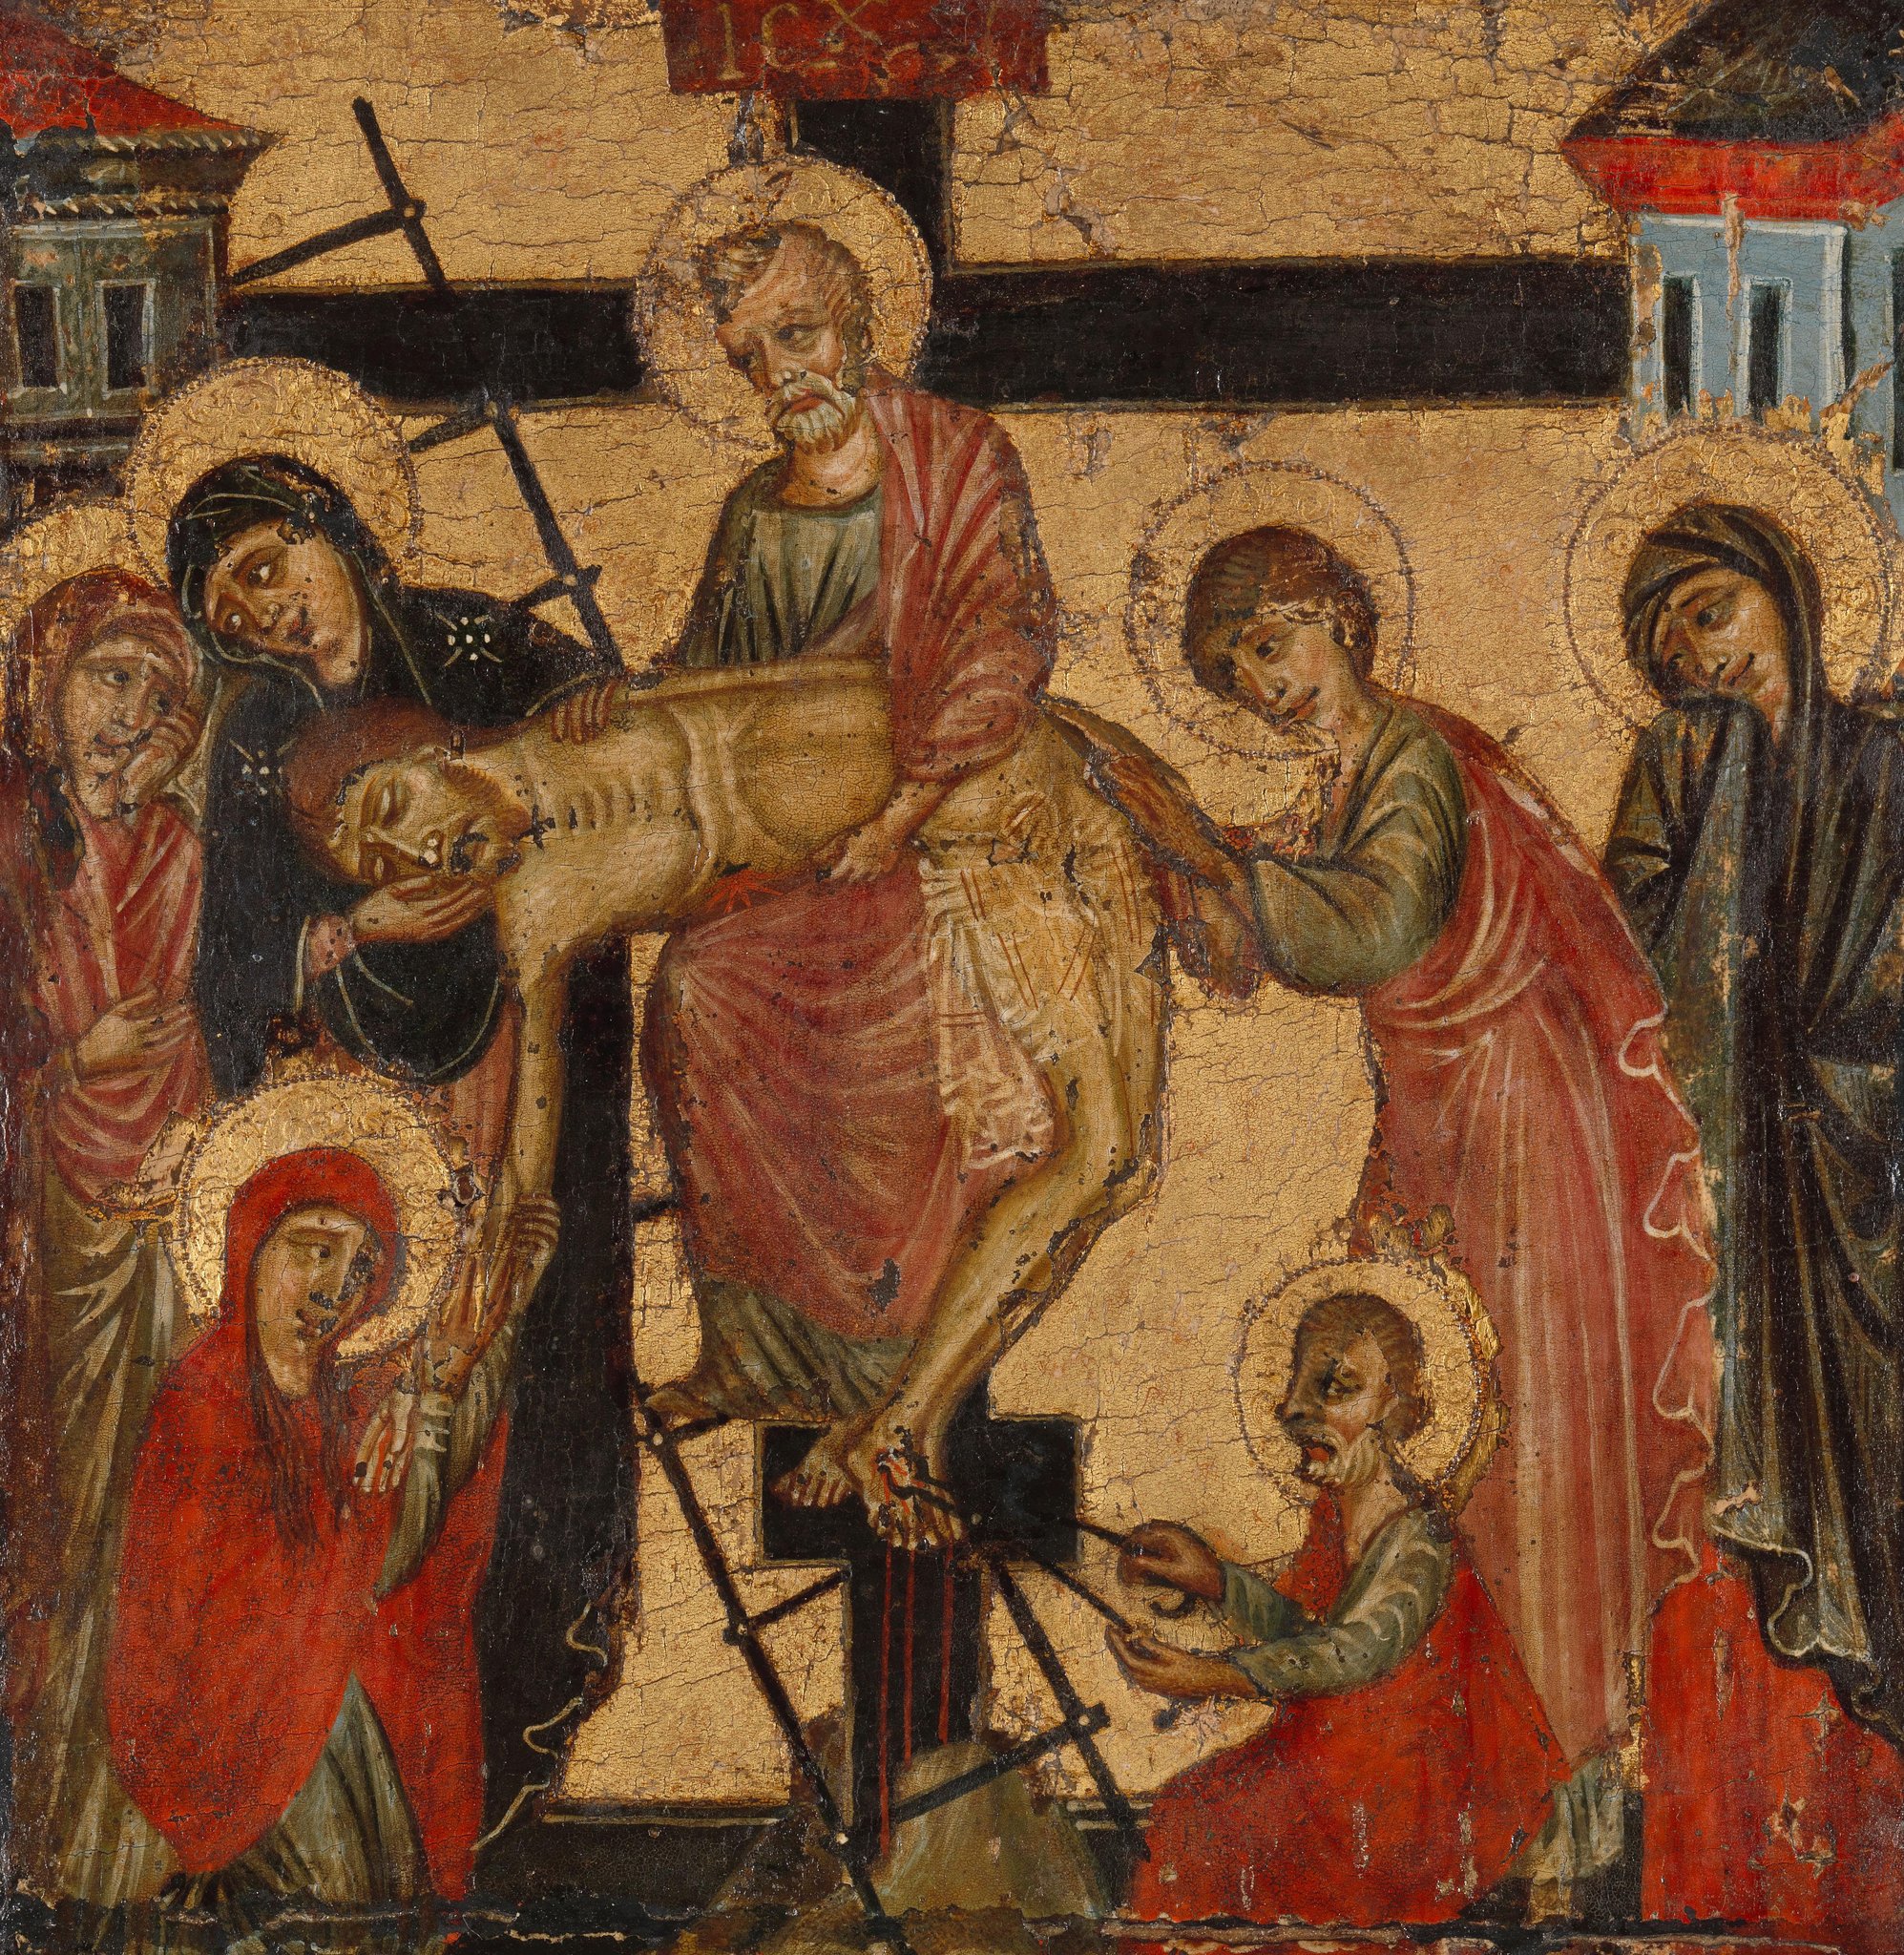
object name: fragment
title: The Deposition and the Entombment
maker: corso di buono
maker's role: painter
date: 1290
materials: panel, paint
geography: pisa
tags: descent from the cross: christ is taken down from the cross, usually by nicodemus and joseph of arimathaea who are standing on the ladders (both arms of christ detached)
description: These two panels are probably fragments from a larger ensemble devoted to the Passion of Christ. The artist followed established conventions for depicting grief and sorrow through gesture. This approach was characteristic of the stiff, rather formulaic style derived from Greek and Byzantine models that was prevalent in 13th-century Italy.